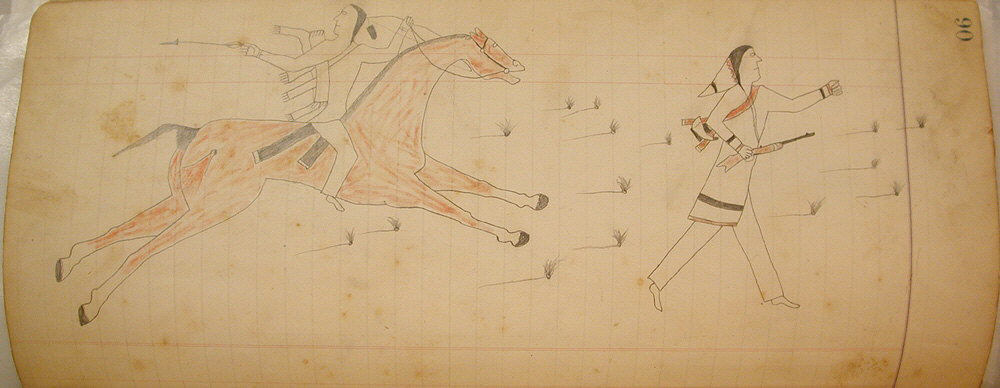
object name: drawing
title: Maffet Ledger: Drawing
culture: cheyenne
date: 1874-1881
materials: crayon, graphite, paper, watercolor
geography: united states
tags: men,horses